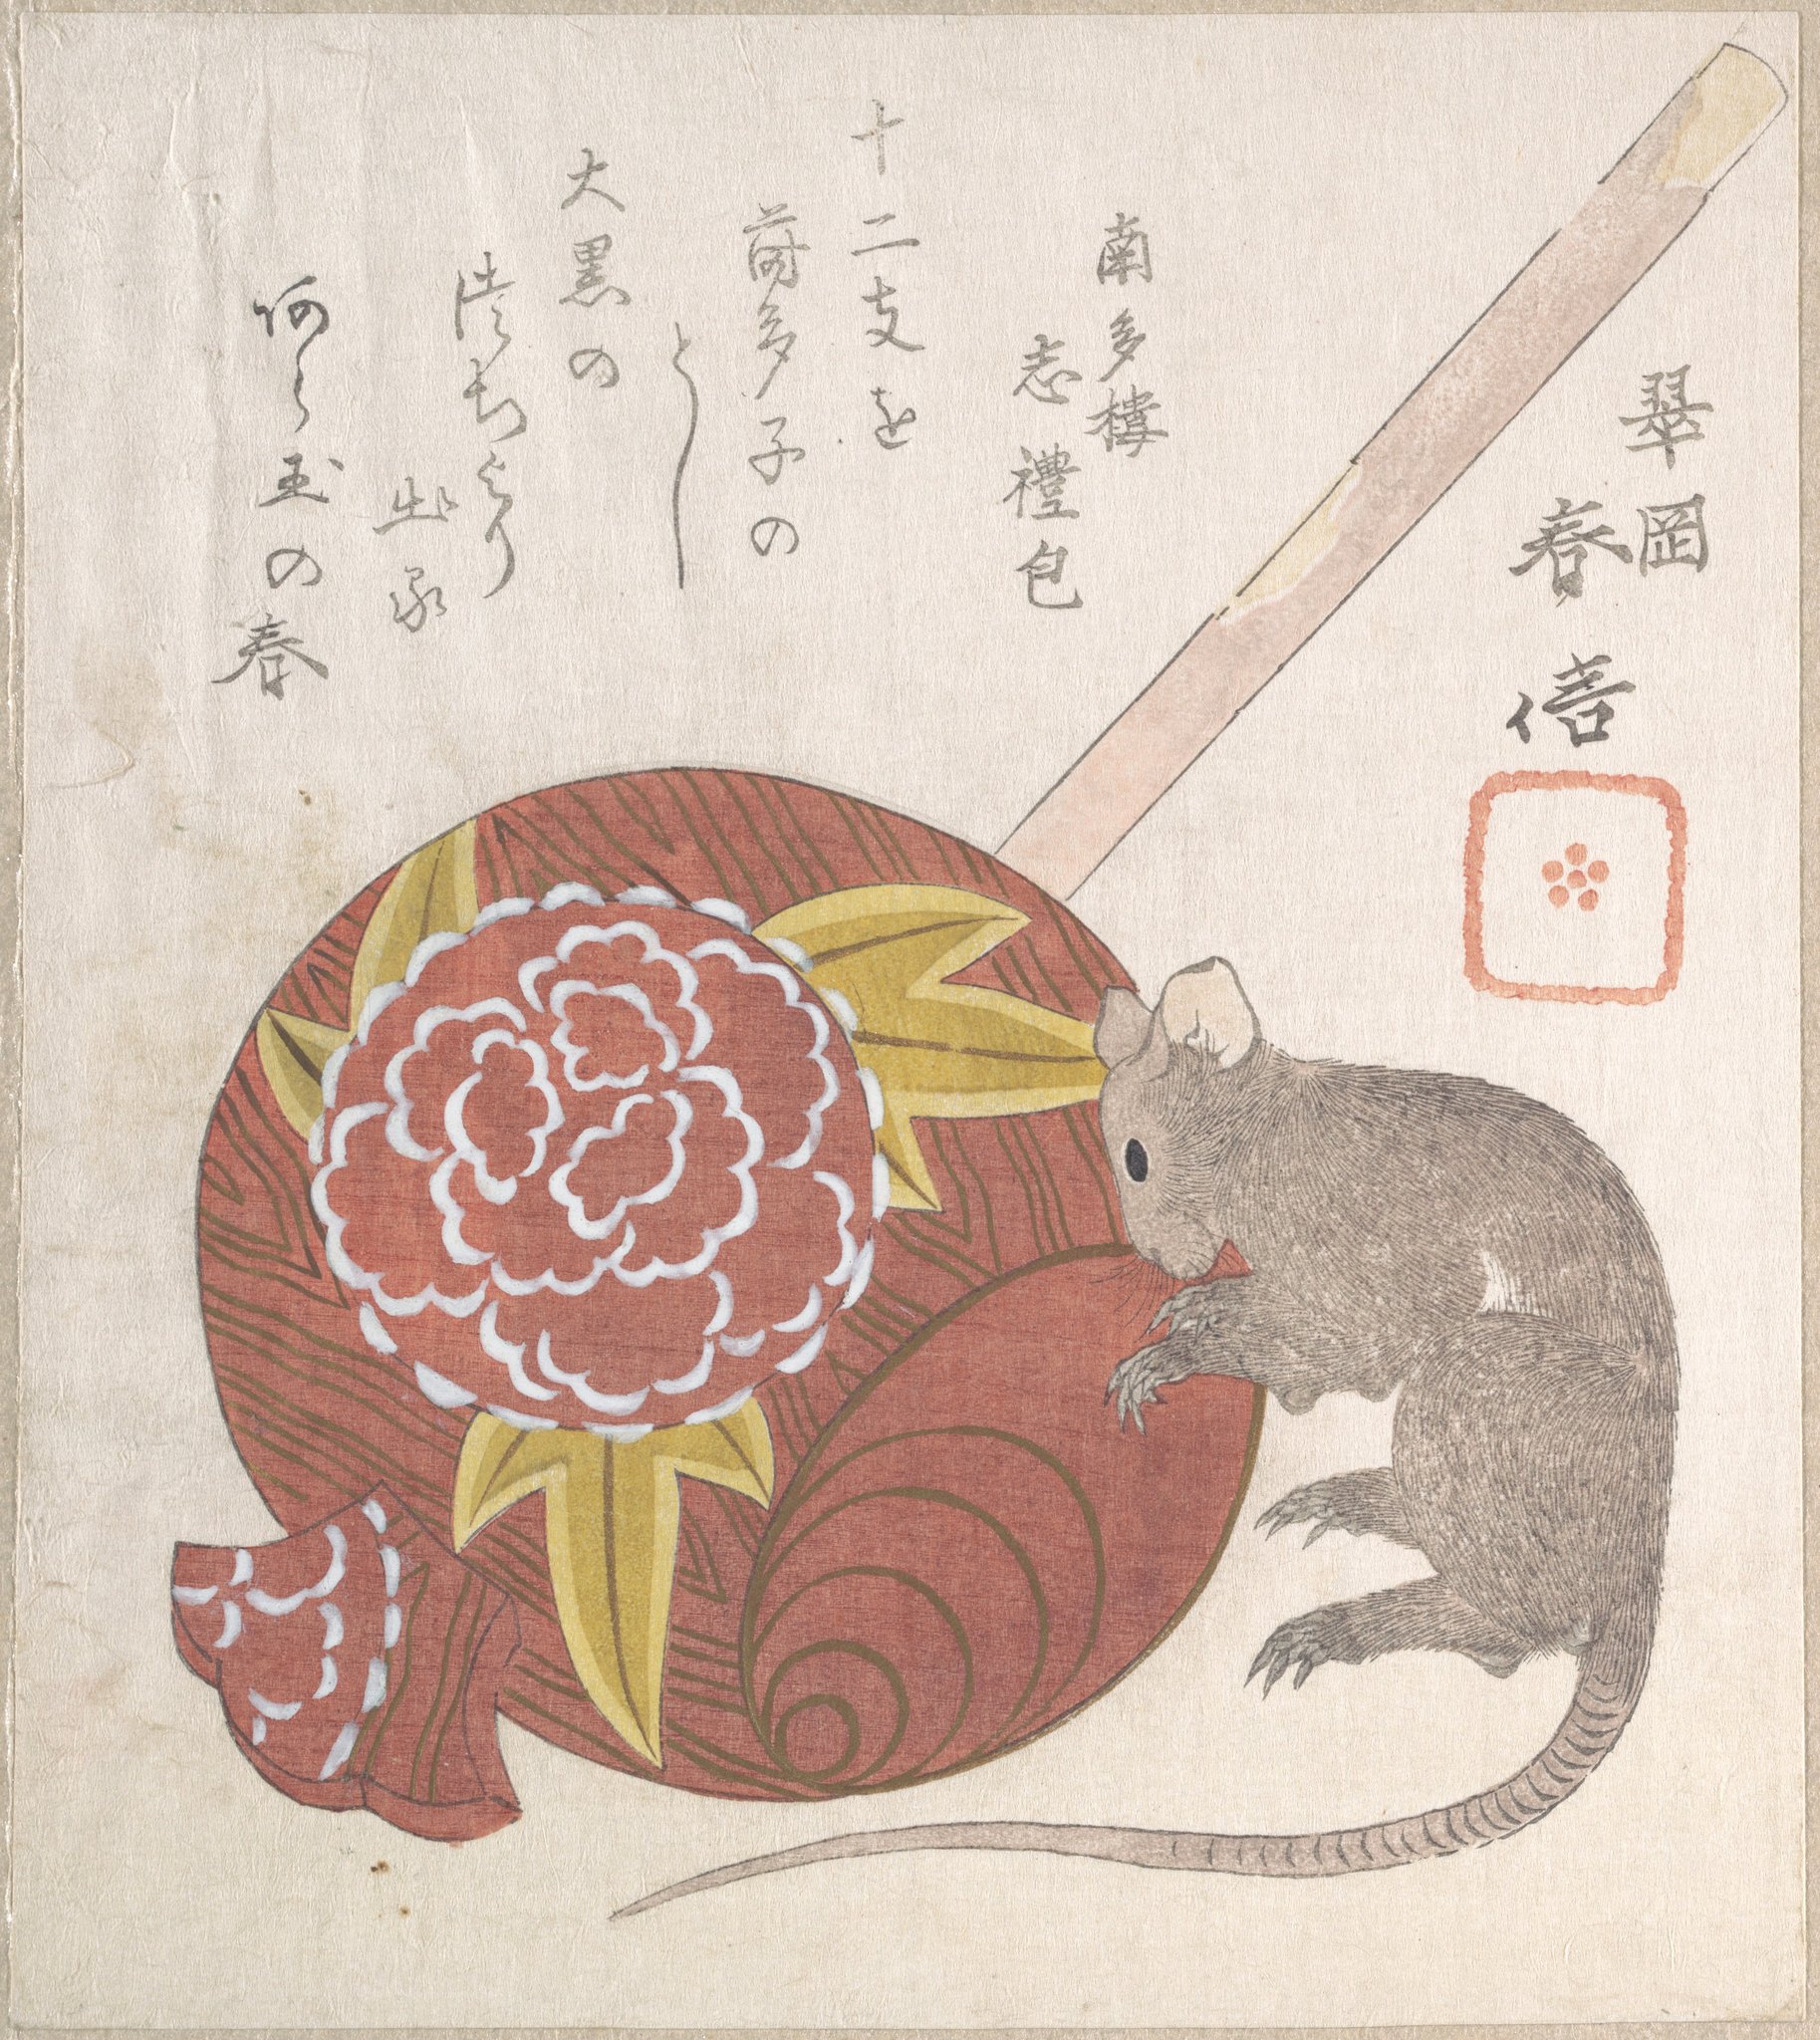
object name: print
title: Mallet of Daikoku, One of the Gods of Good Fortune, and a Rat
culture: japanese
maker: yashima gakutei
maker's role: artist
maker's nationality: japanese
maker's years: 1786-1868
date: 1828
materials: ink, paper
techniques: surimono, woodblock print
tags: rats